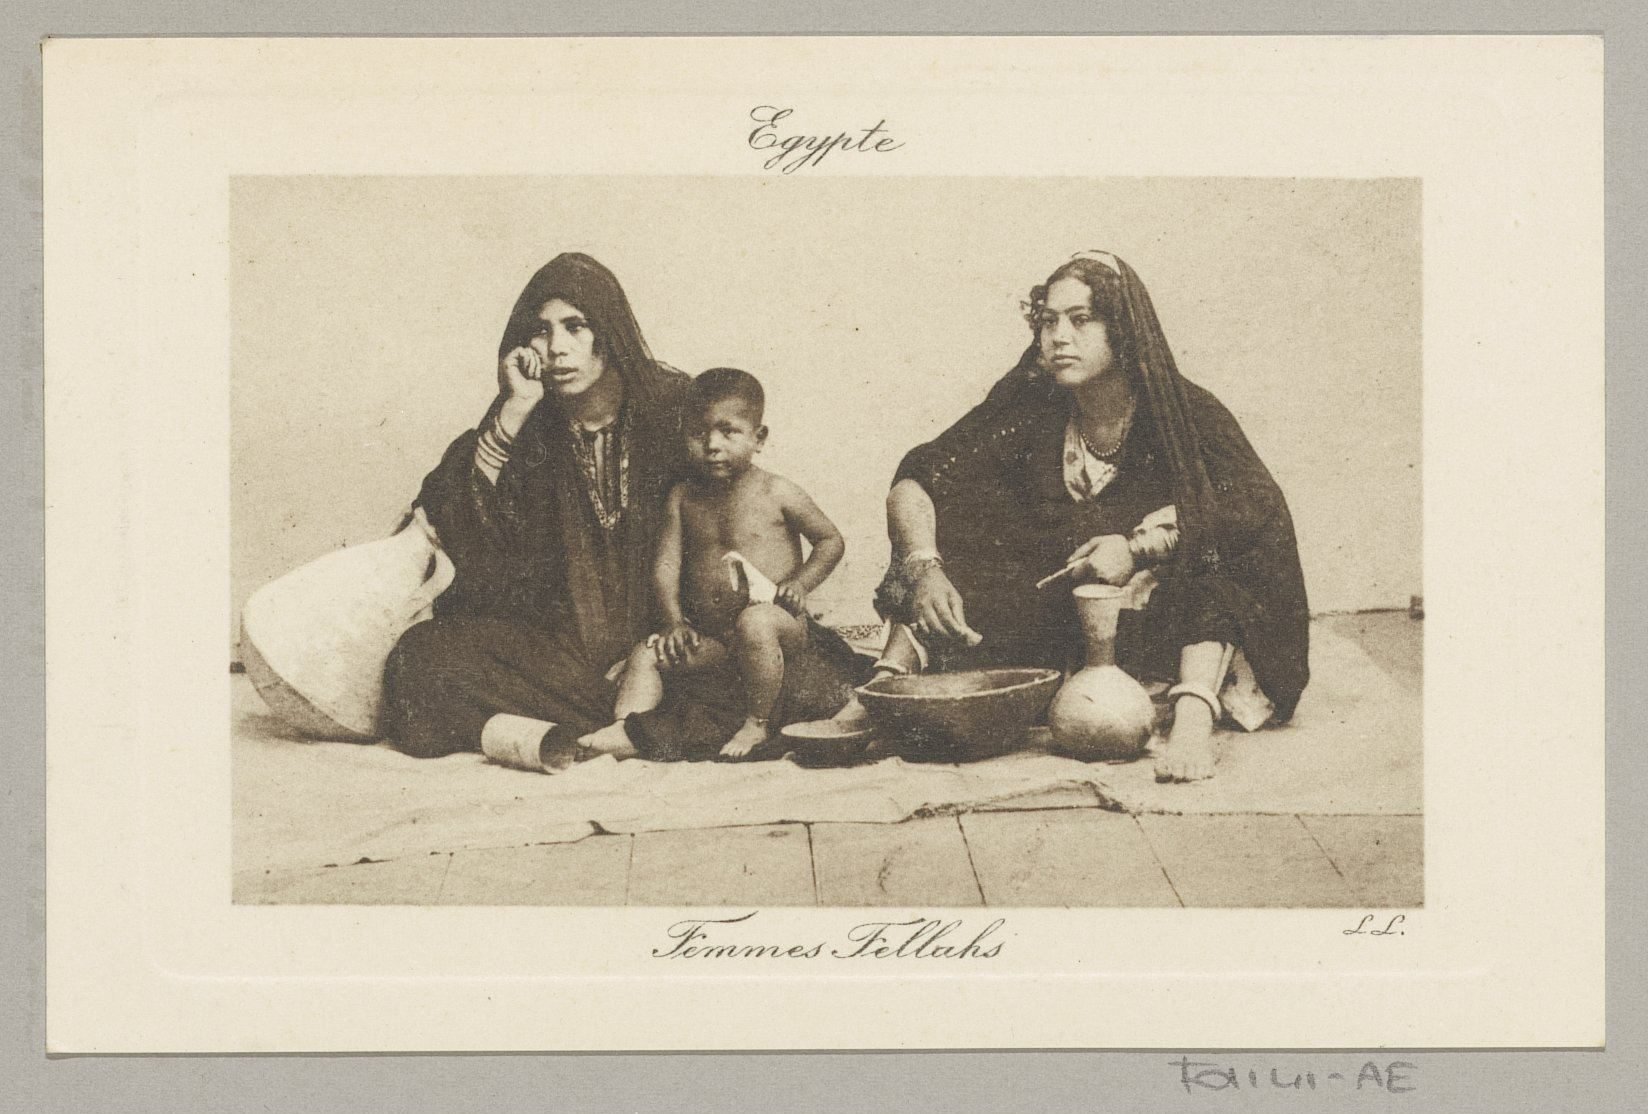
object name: photomechanical print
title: Egypte, Femmes Fellahs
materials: paper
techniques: photograph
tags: farmers - aa - female farmer, farmer's wife, mother and baby or young child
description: Onderdeel van Fotoalbum van een reis door Zuid-Europa en het Midden-Oosten.